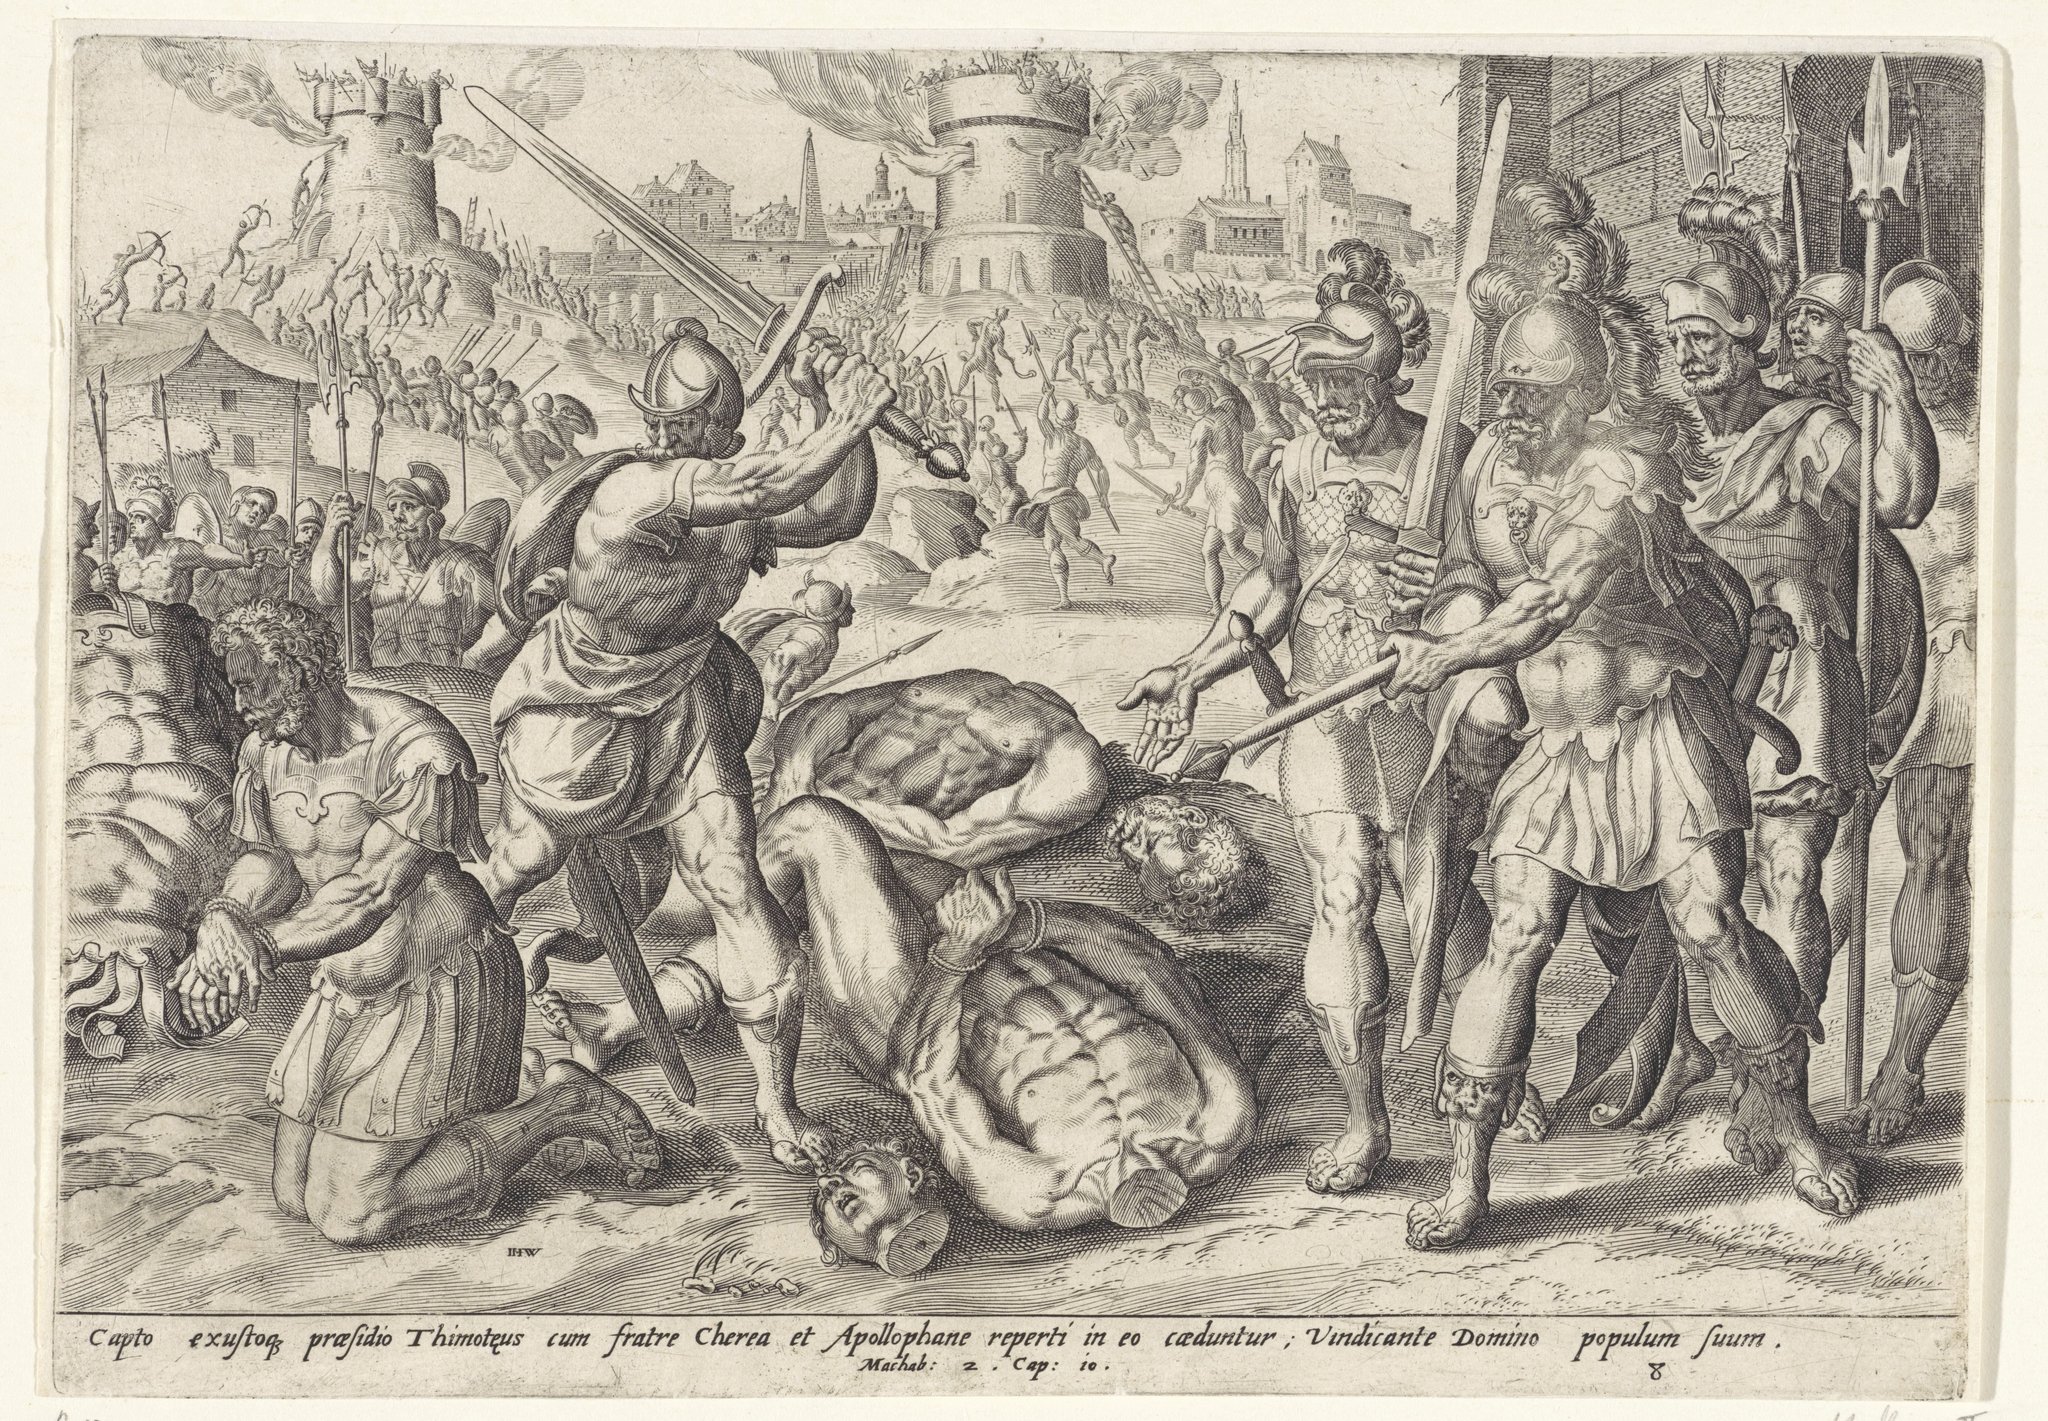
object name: print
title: Thesaurus sacrarum historiarum veteris testamenti (...)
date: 1579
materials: paper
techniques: engraving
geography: antwerp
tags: other scenes ~ second book of the maccabees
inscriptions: collector's mark: Lugt 2228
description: Het leger van Judas Makkabeeër bestormt de muren van de burcht. Ze steken de torens in brand. Timoteüs en zijn broers Chereas en Apollofanes worden gedood. Onder de voorstelling een verwijzing in het Latijn naar de Bijbeltekst in 2 Makk. 10.